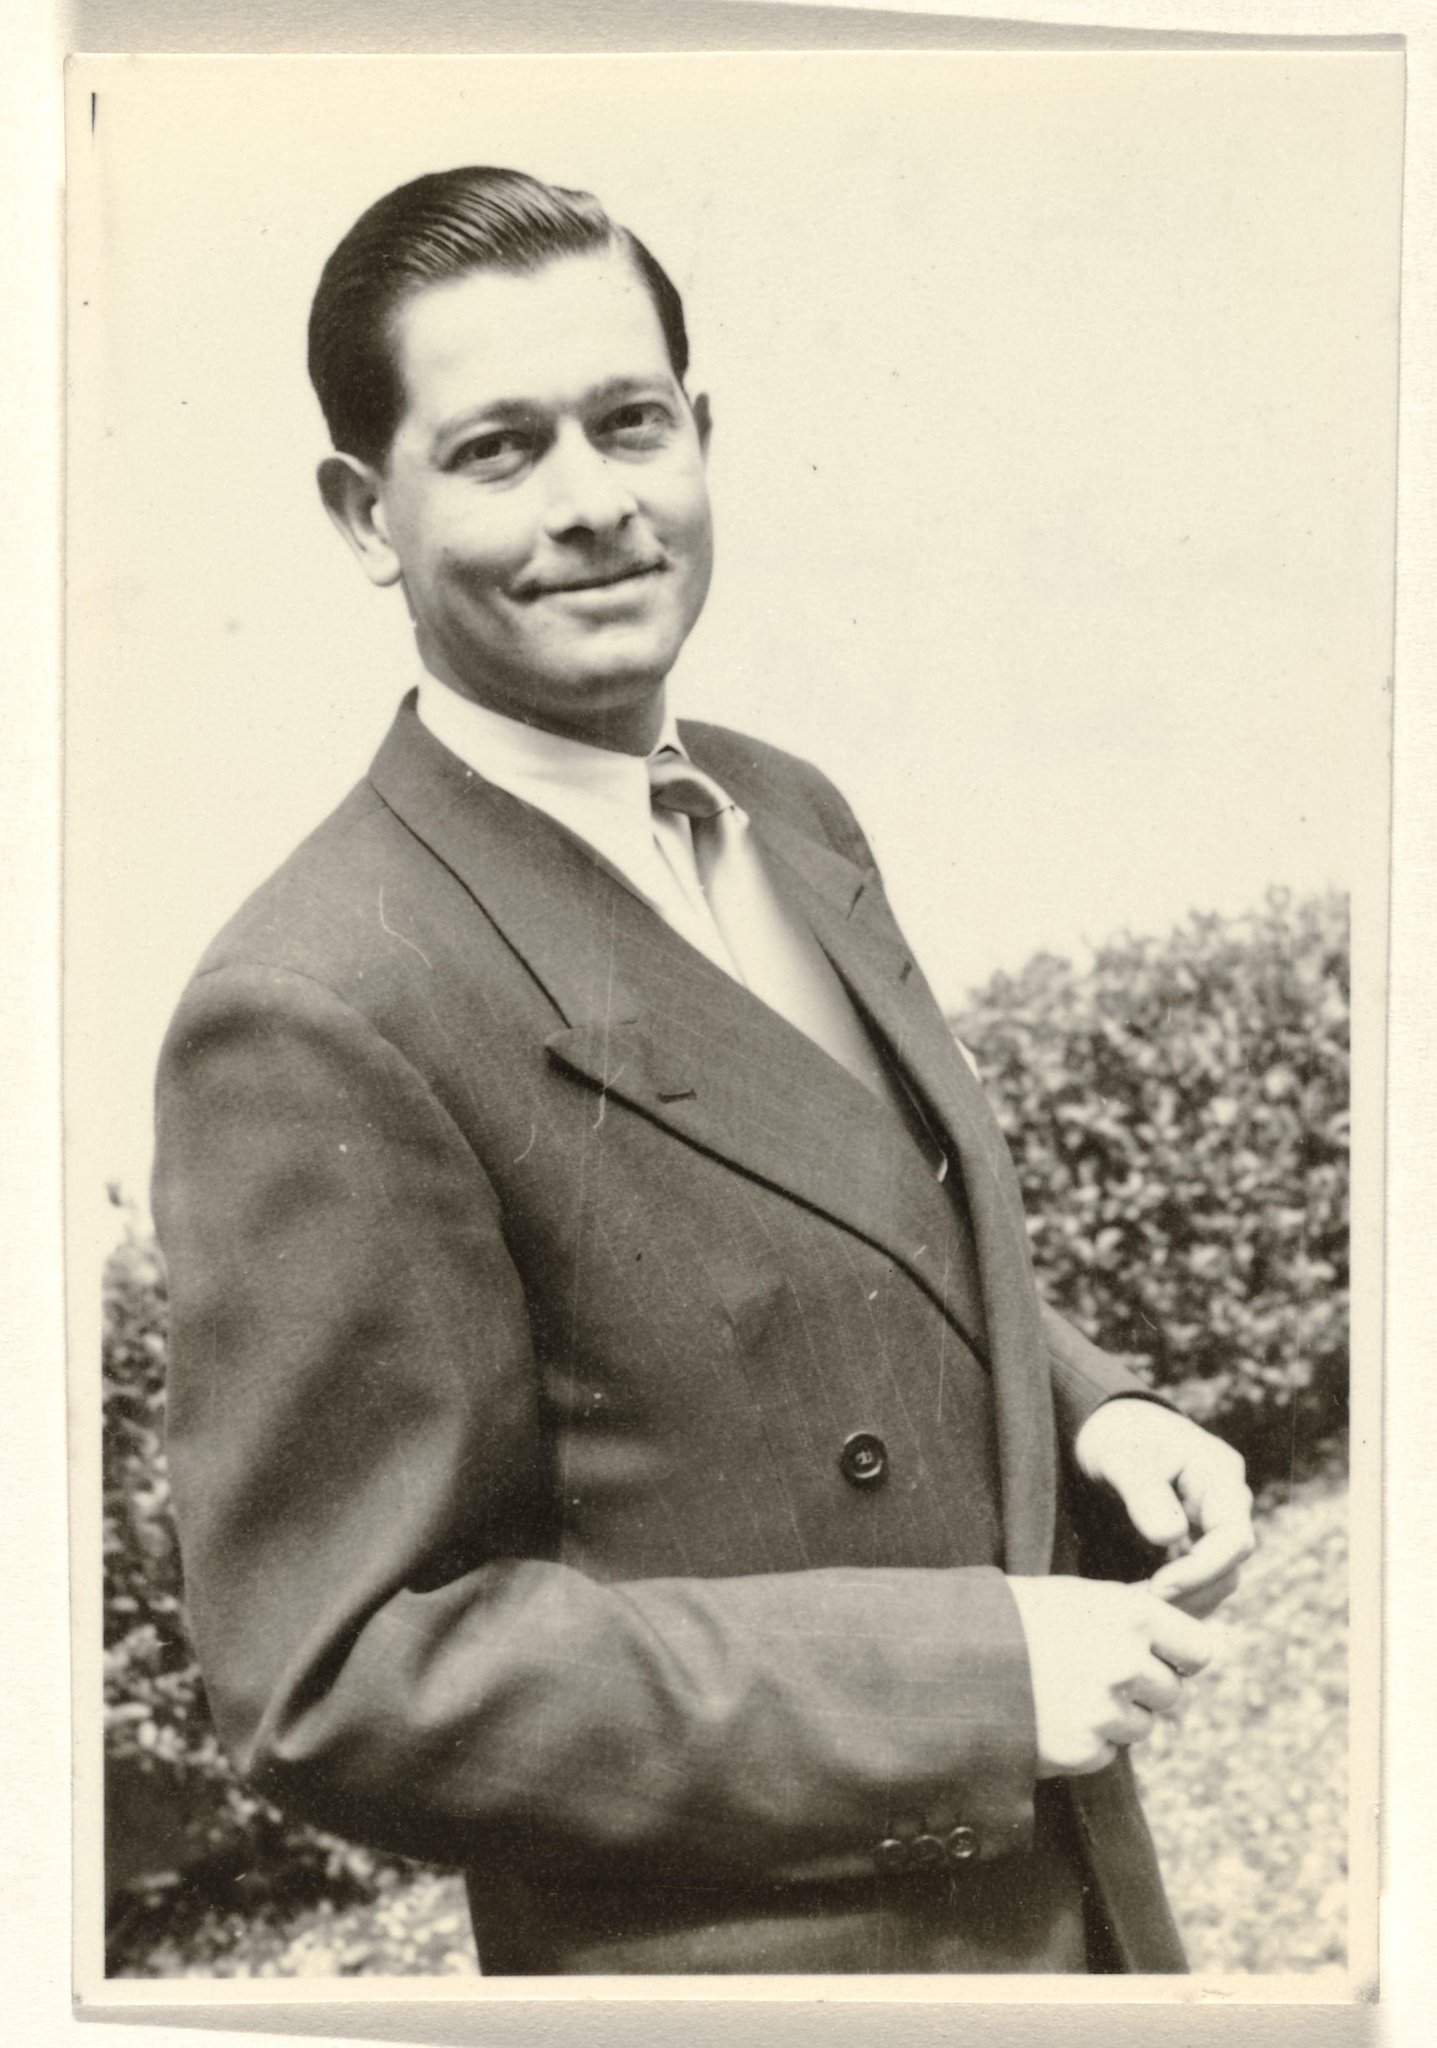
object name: photograph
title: Onbekende lachende man, met een haag op de achtergrond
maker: Anonymous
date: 1951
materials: photographic support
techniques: gelatin silver print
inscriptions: inscription: ‘May 5th, 1951 Myself smiling and with reason.’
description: Onbekende lachende man, met een haag op de achtergrond.